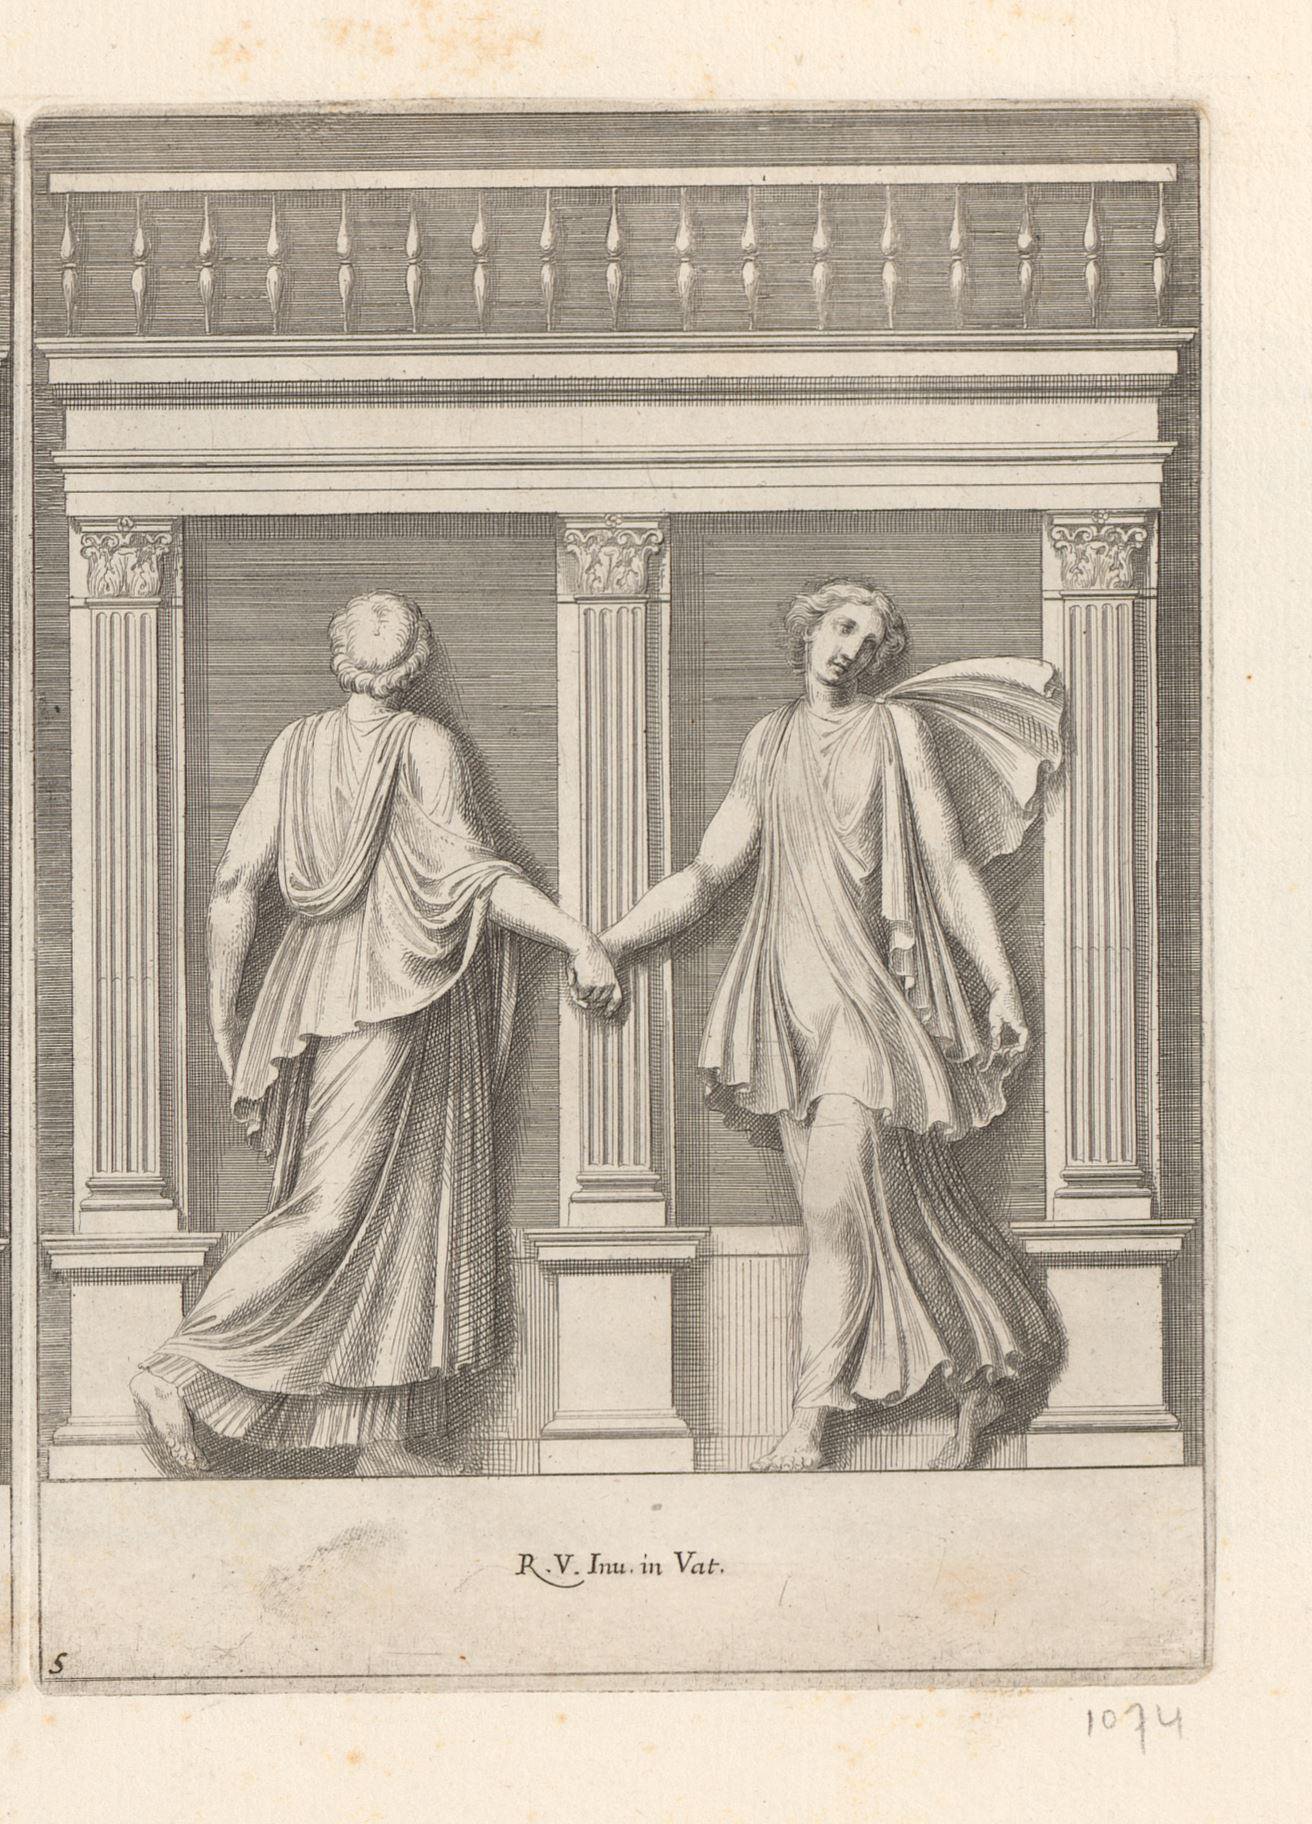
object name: print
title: Reliëfs in de Loggia van Rafaël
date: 1645-1700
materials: paper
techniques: engraving, etching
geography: vatican city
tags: adult woman, dancing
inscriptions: number: ‘38’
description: Prent uit een reeks naar de gipsen reliëfs door Rafaël en uitgevoerd door zijn assistenten in de Vaticaanse Loggia.